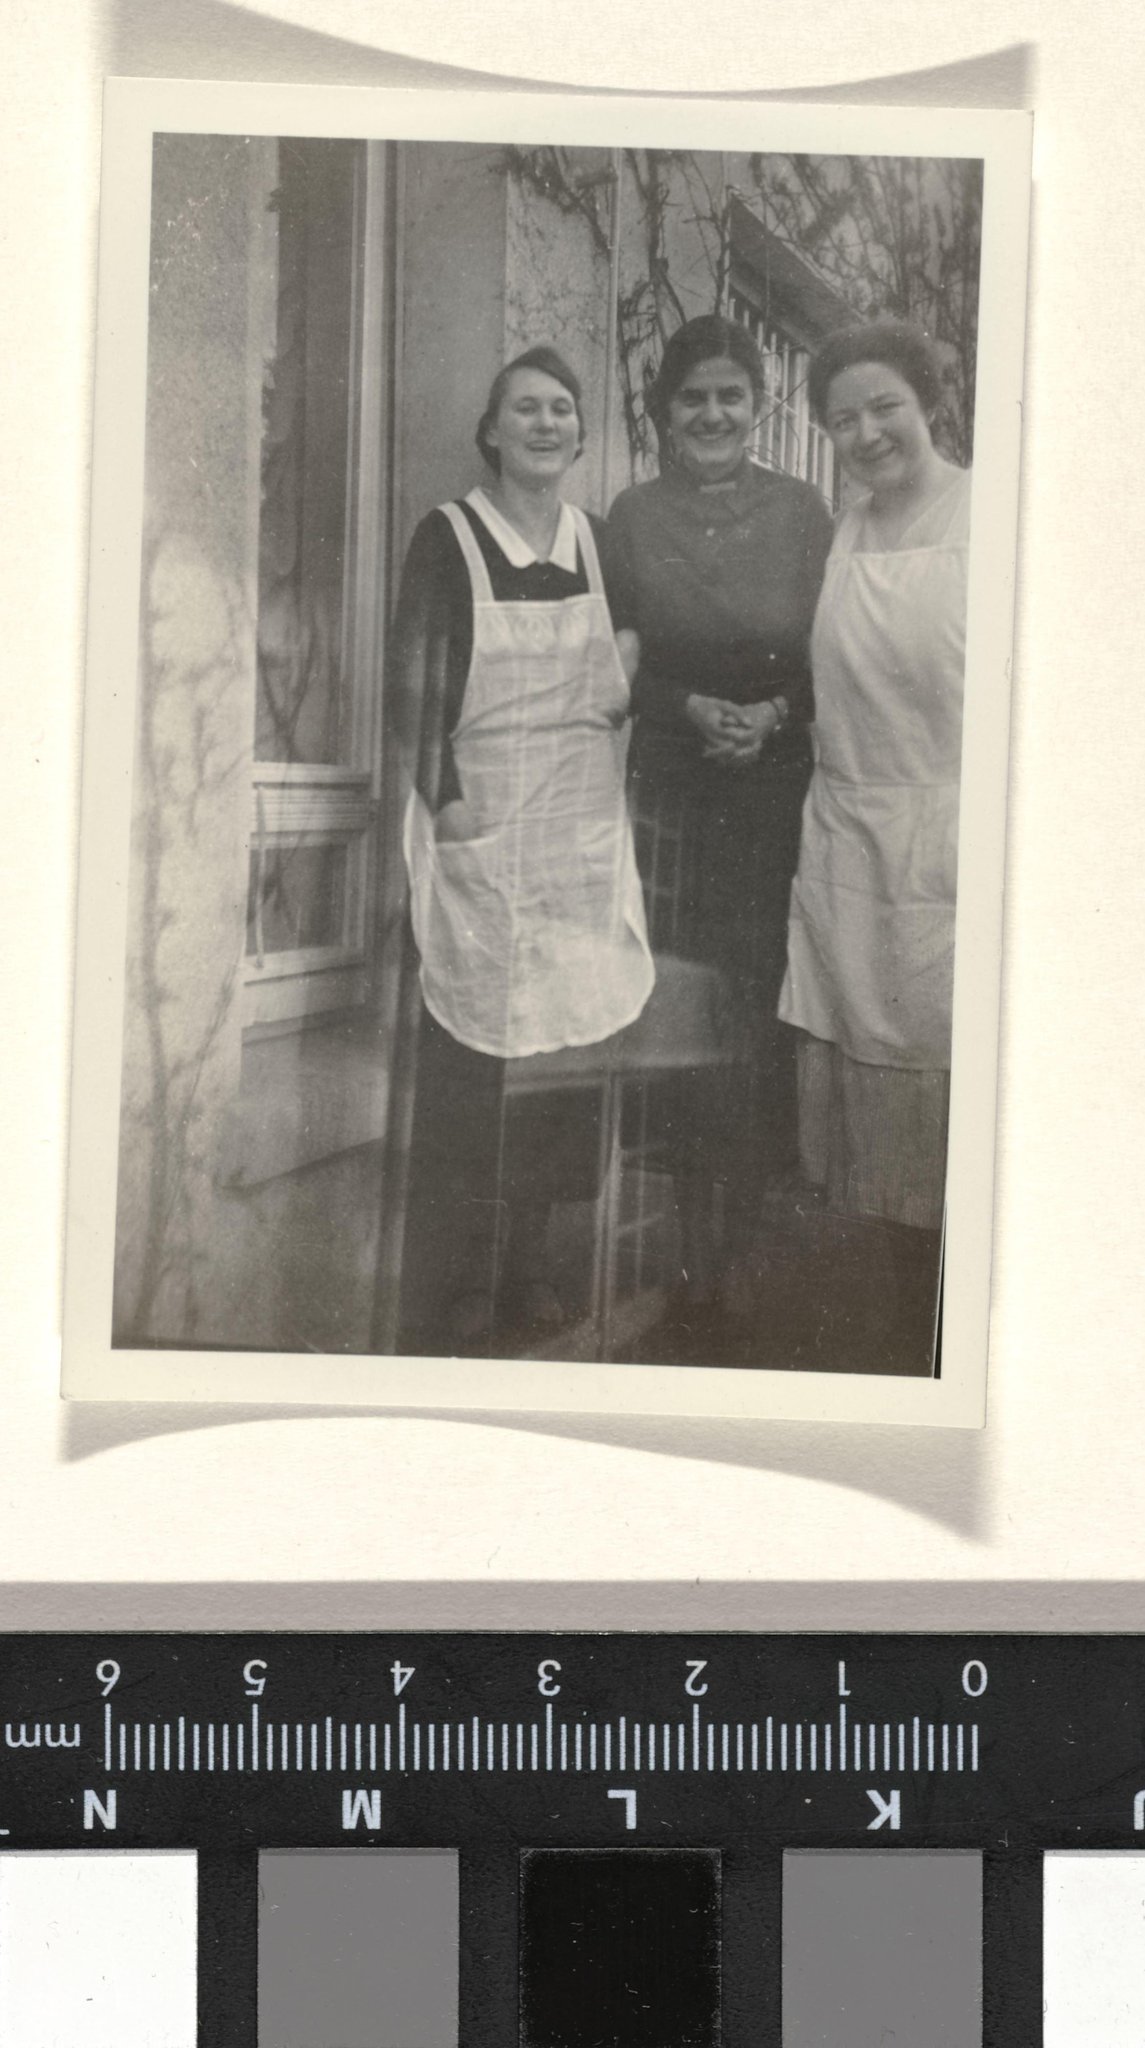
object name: photograph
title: Drie onbekende leden van de huishoudelijke staf van de familie Wachenheimer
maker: Anonymous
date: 1928-1937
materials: photographic support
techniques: gelatin silver print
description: Drie onbekende leden van de huishoudelijke staf van de familie Wachenheimer, één in zwarte kleding met een schort voor (links), het vermoedelijke kindermeisje van de familie Wachenheimer in donkere kleding (midden) en één in lichte kleding (rechts), staand voor een huis.